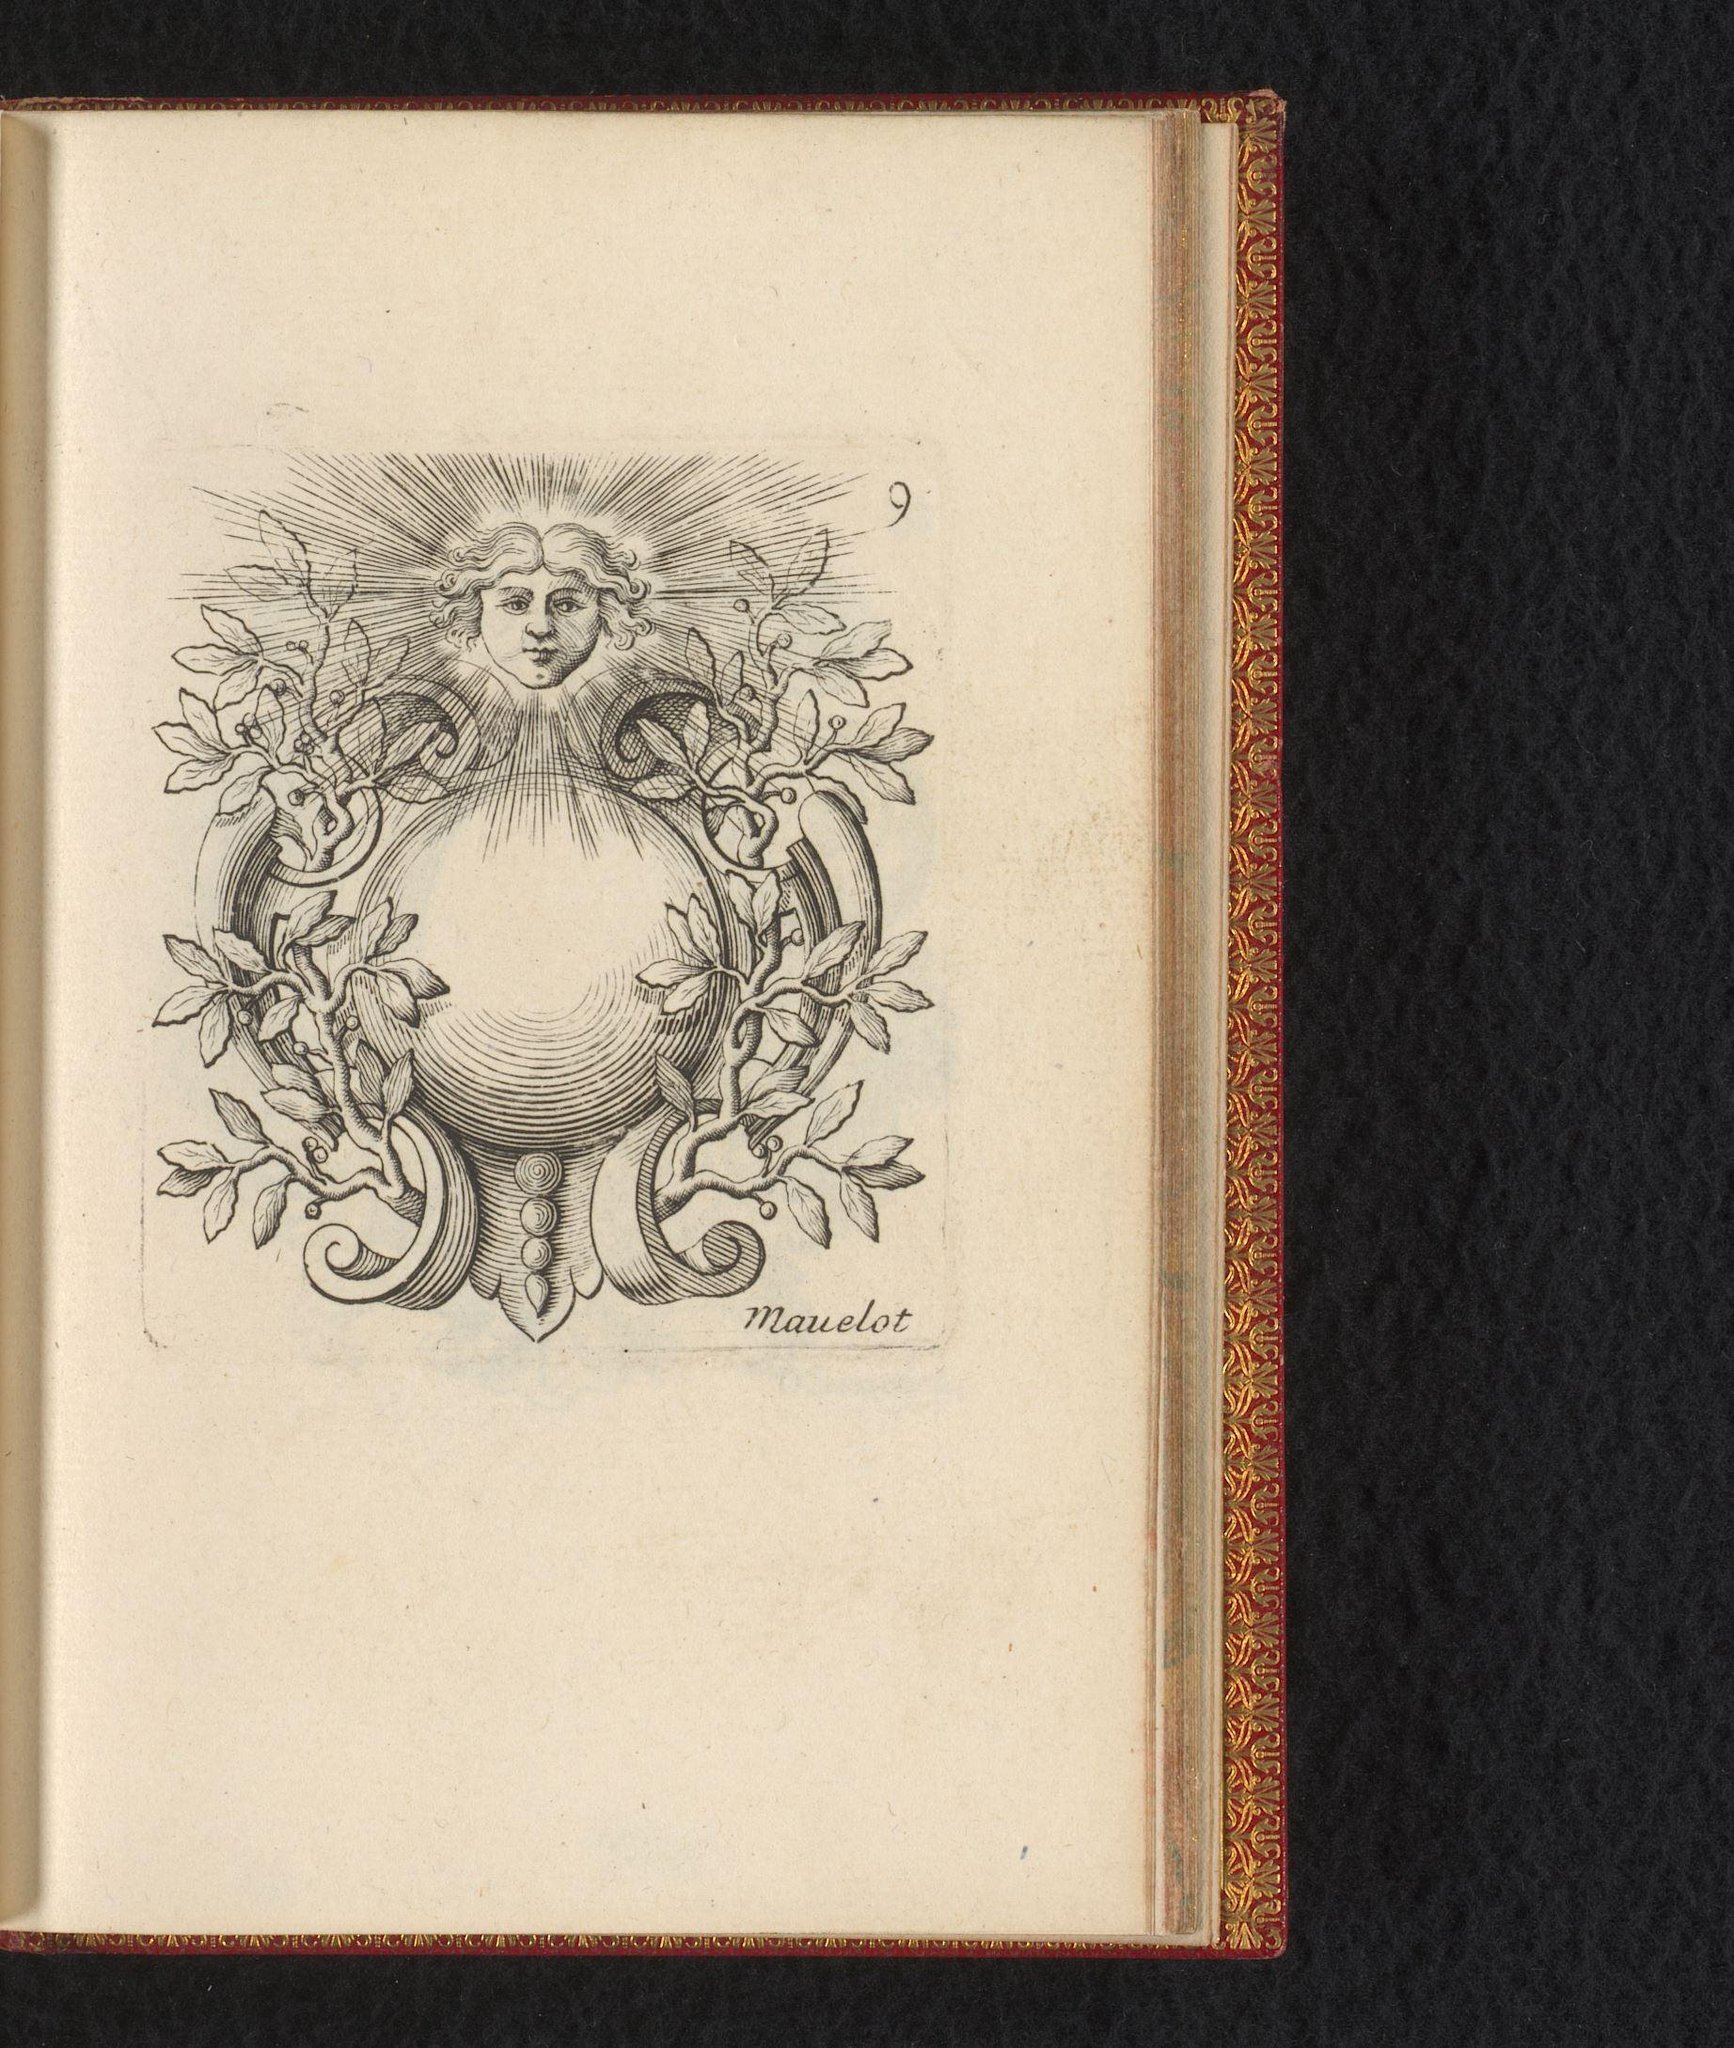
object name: album leaf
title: Cartouche met gezicht omringd door zonnestralen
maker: charles mavelot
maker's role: draughtsman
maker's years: 1680-1742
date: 1685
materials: paper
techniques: engraving, etching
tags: sun represented as face, wheel, etc., sunbeams, ornament ~ cartouche, foliage, tendrils, branches ~ ornament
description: Rechtsboven genummerd: 9. Prent maakt deel uit van een album.